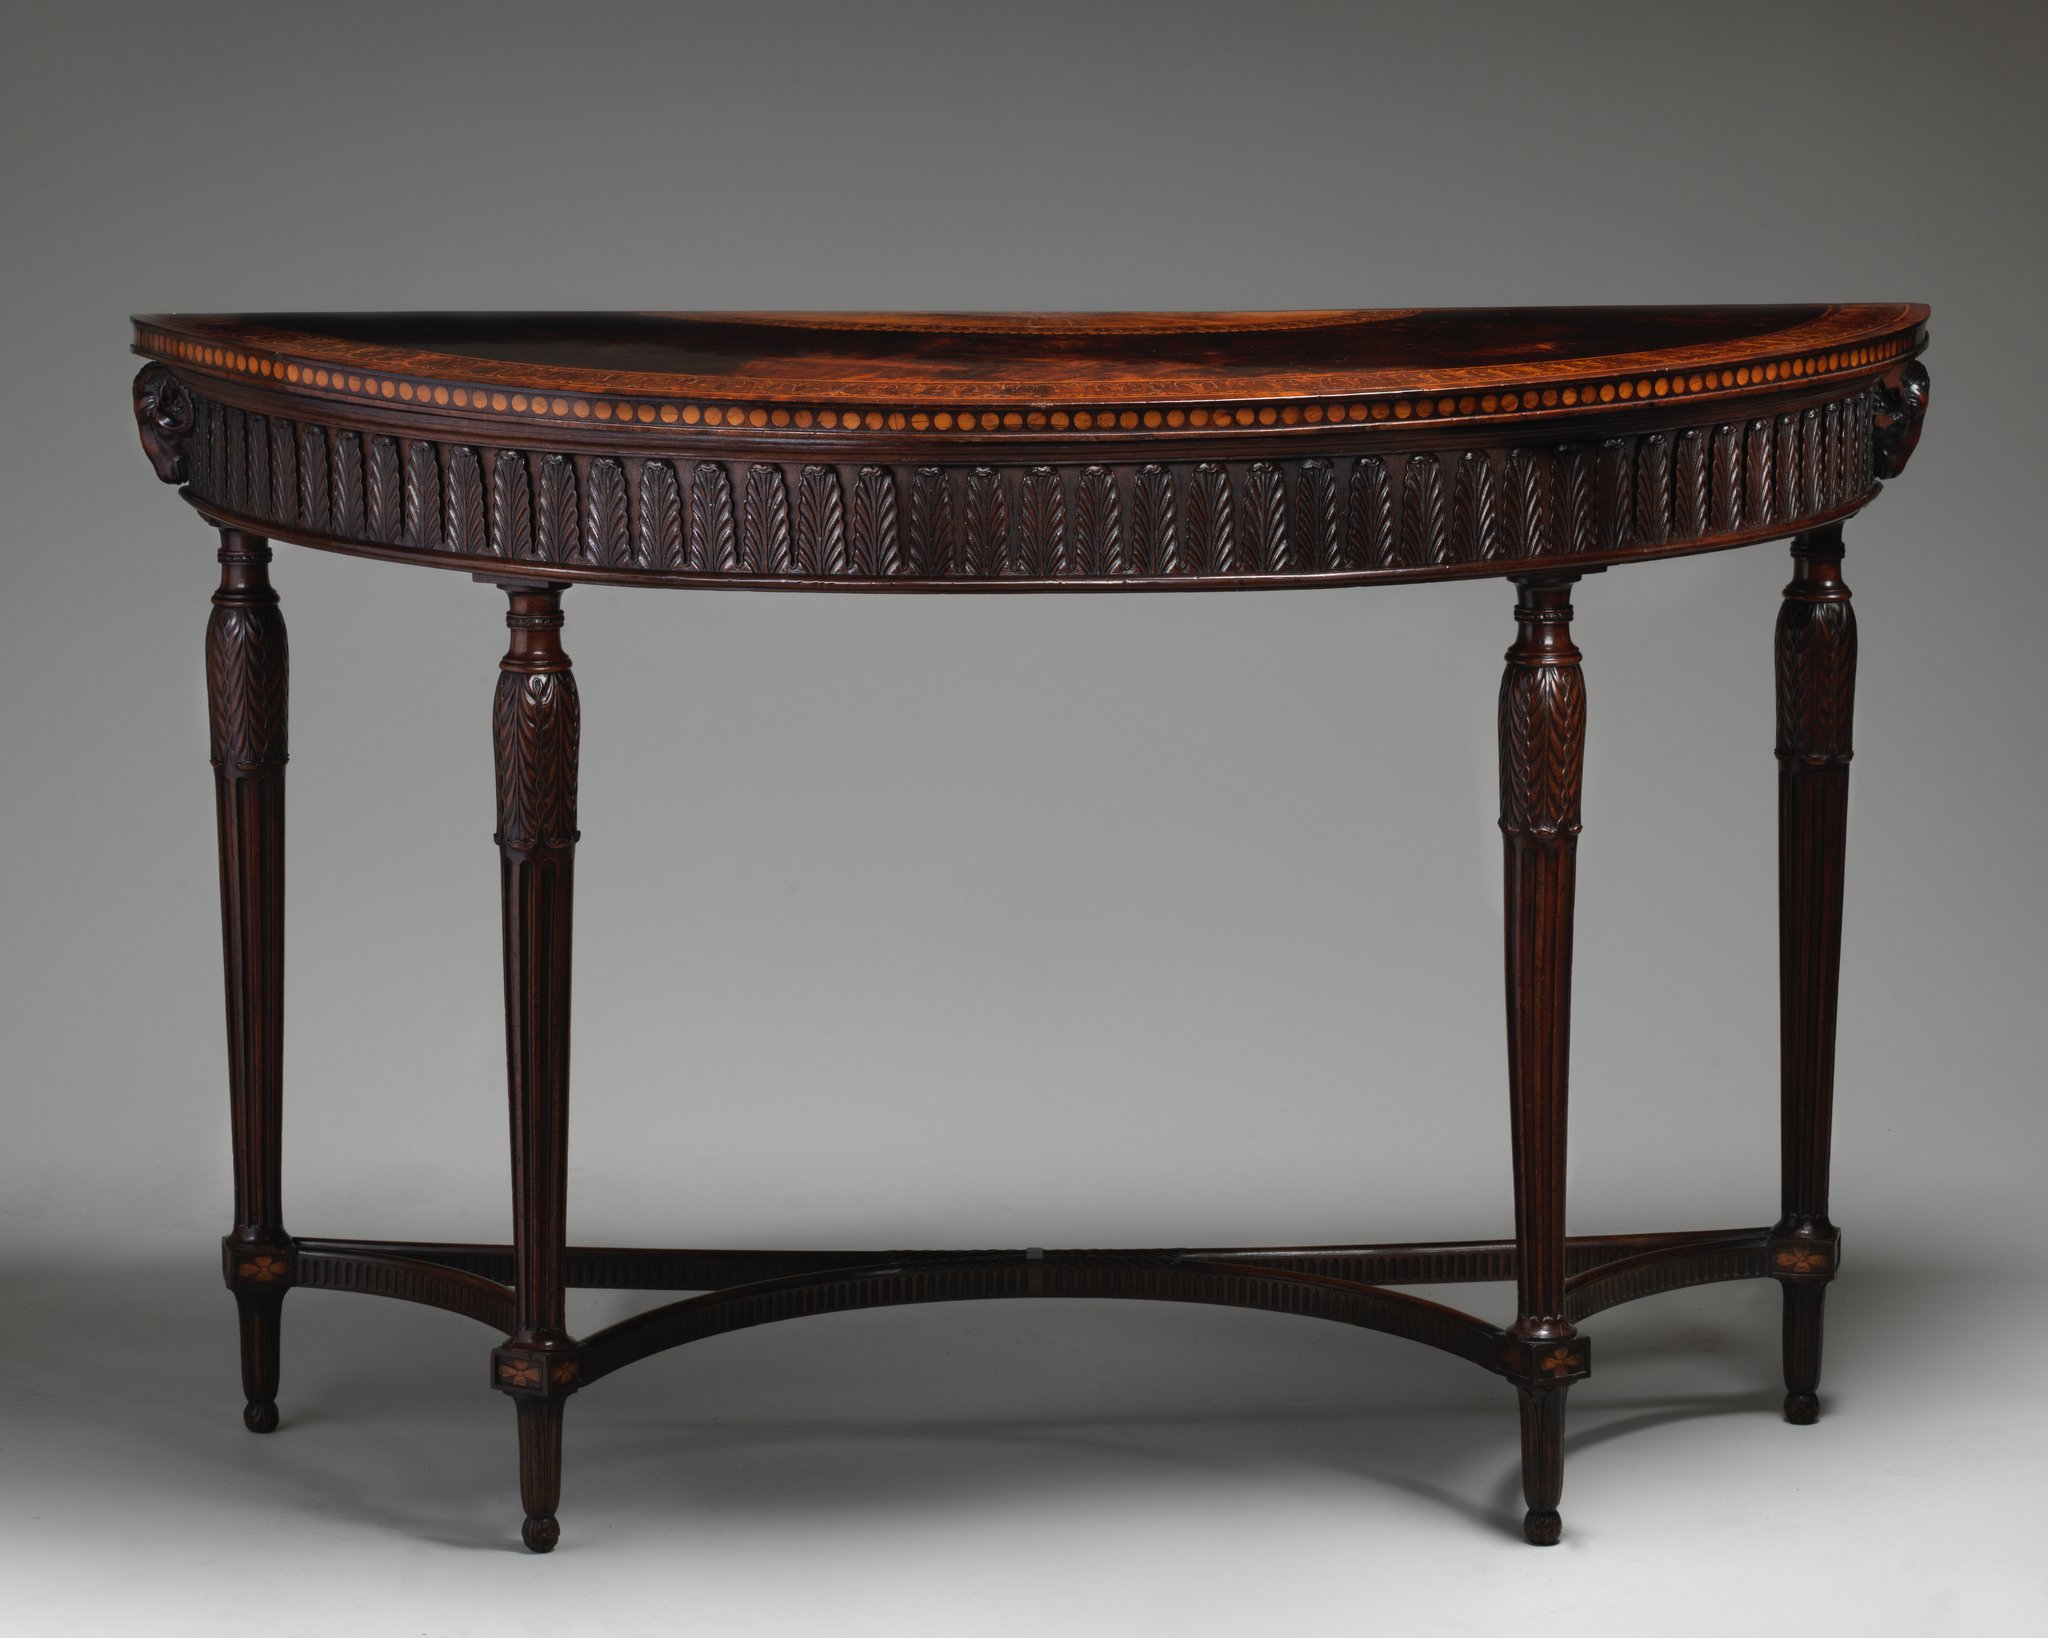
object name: side table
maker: robert adam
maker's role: designer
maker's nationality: british, scottish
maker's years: 1728-1792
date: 1780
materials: wood